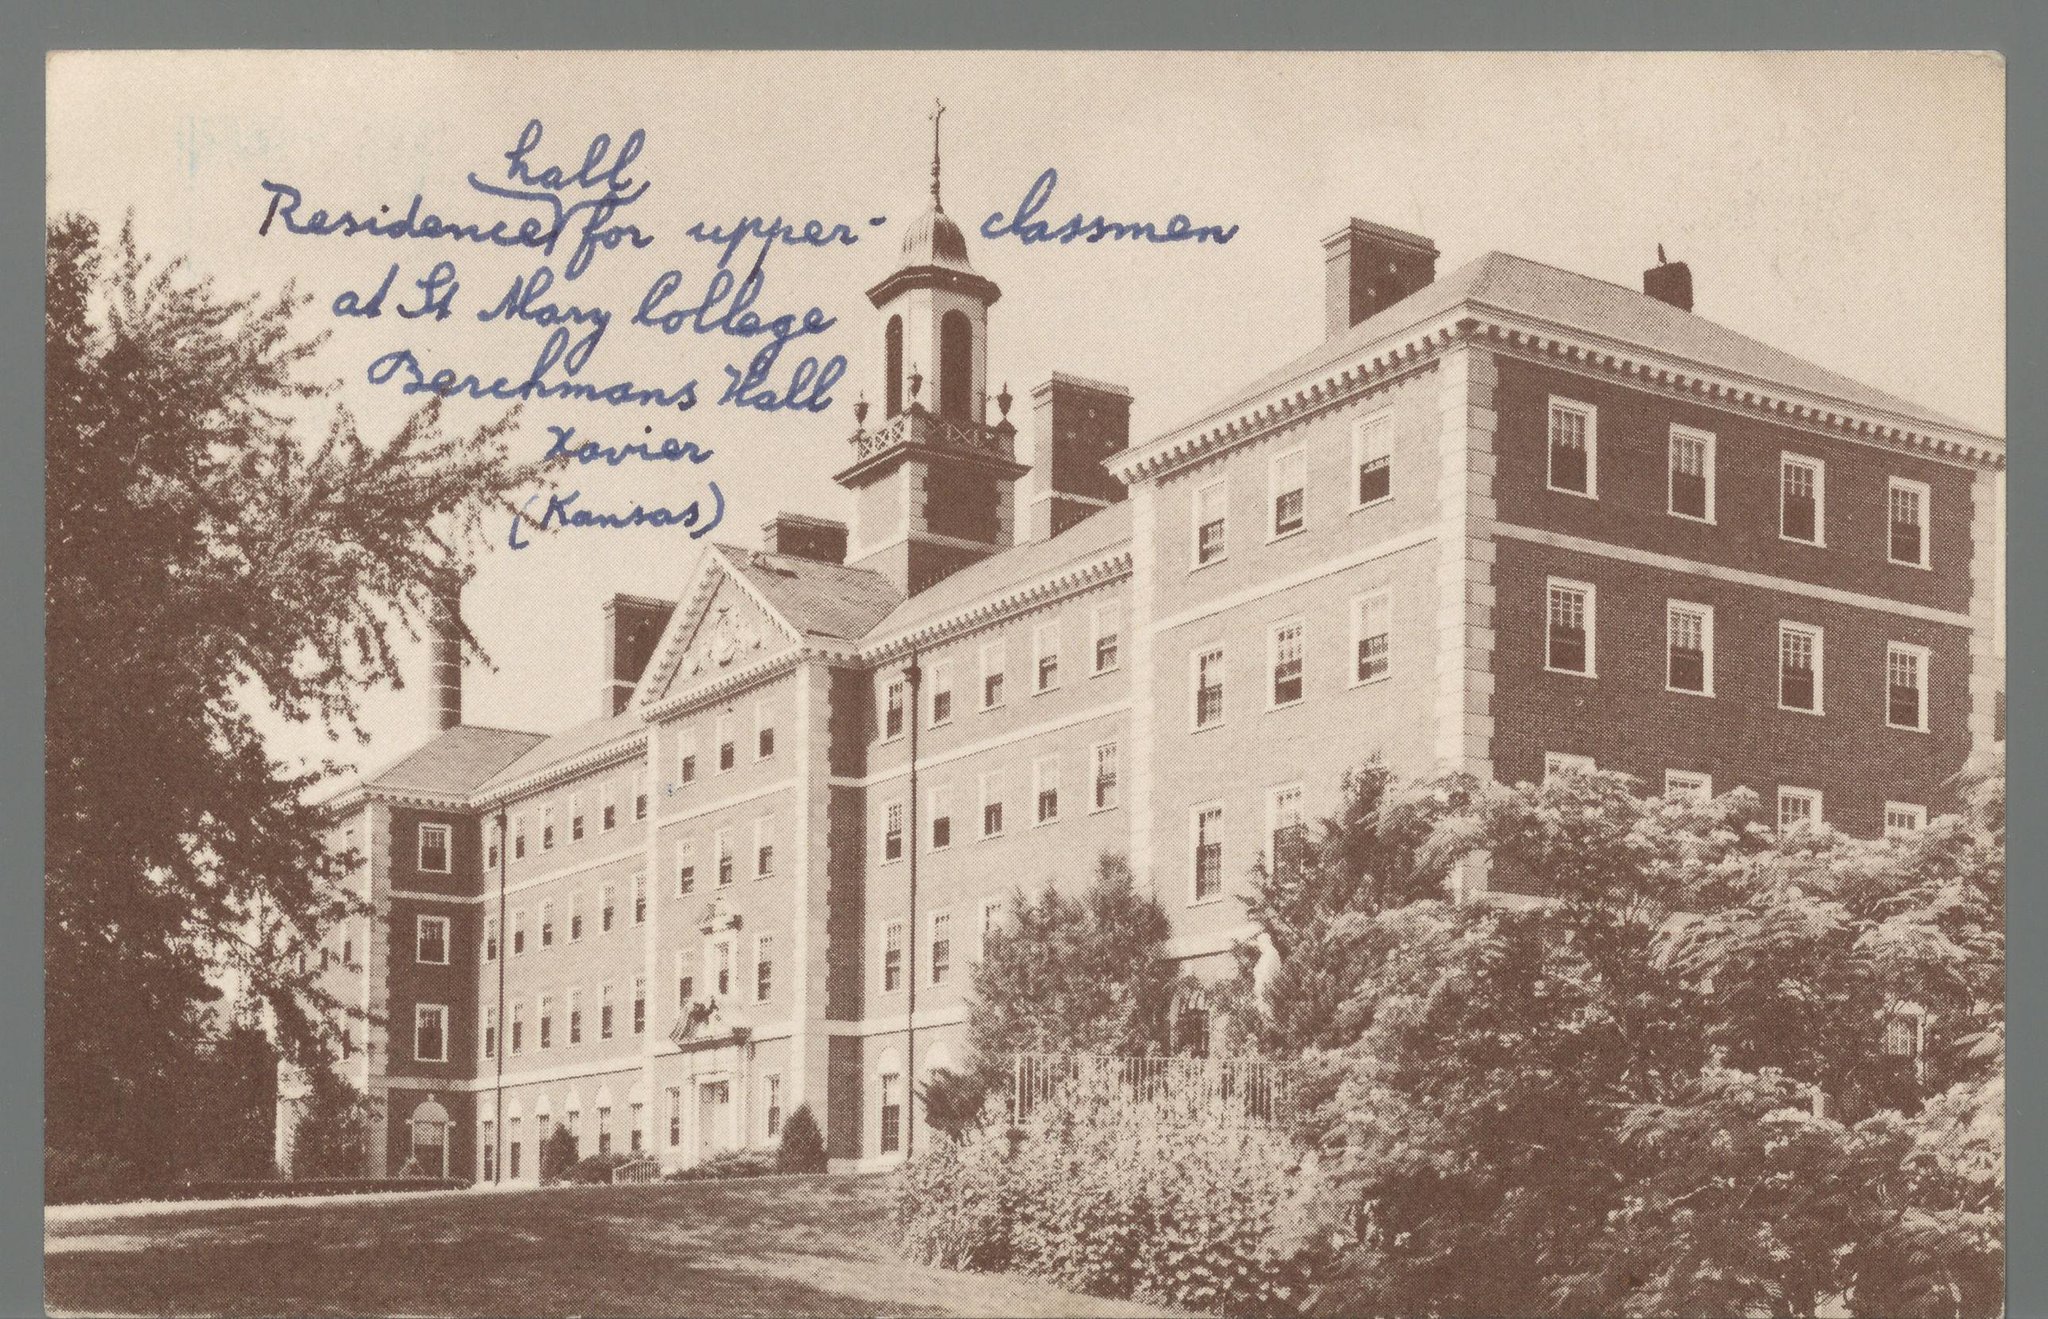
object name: photomechanical print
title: Berchmans Hall. Xavier, Kansas. Residence hall for upperclassmen at Saint Mary College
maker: Anonymous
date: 1907-1959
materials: cardboard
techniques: writing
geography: xavier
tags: university building, college